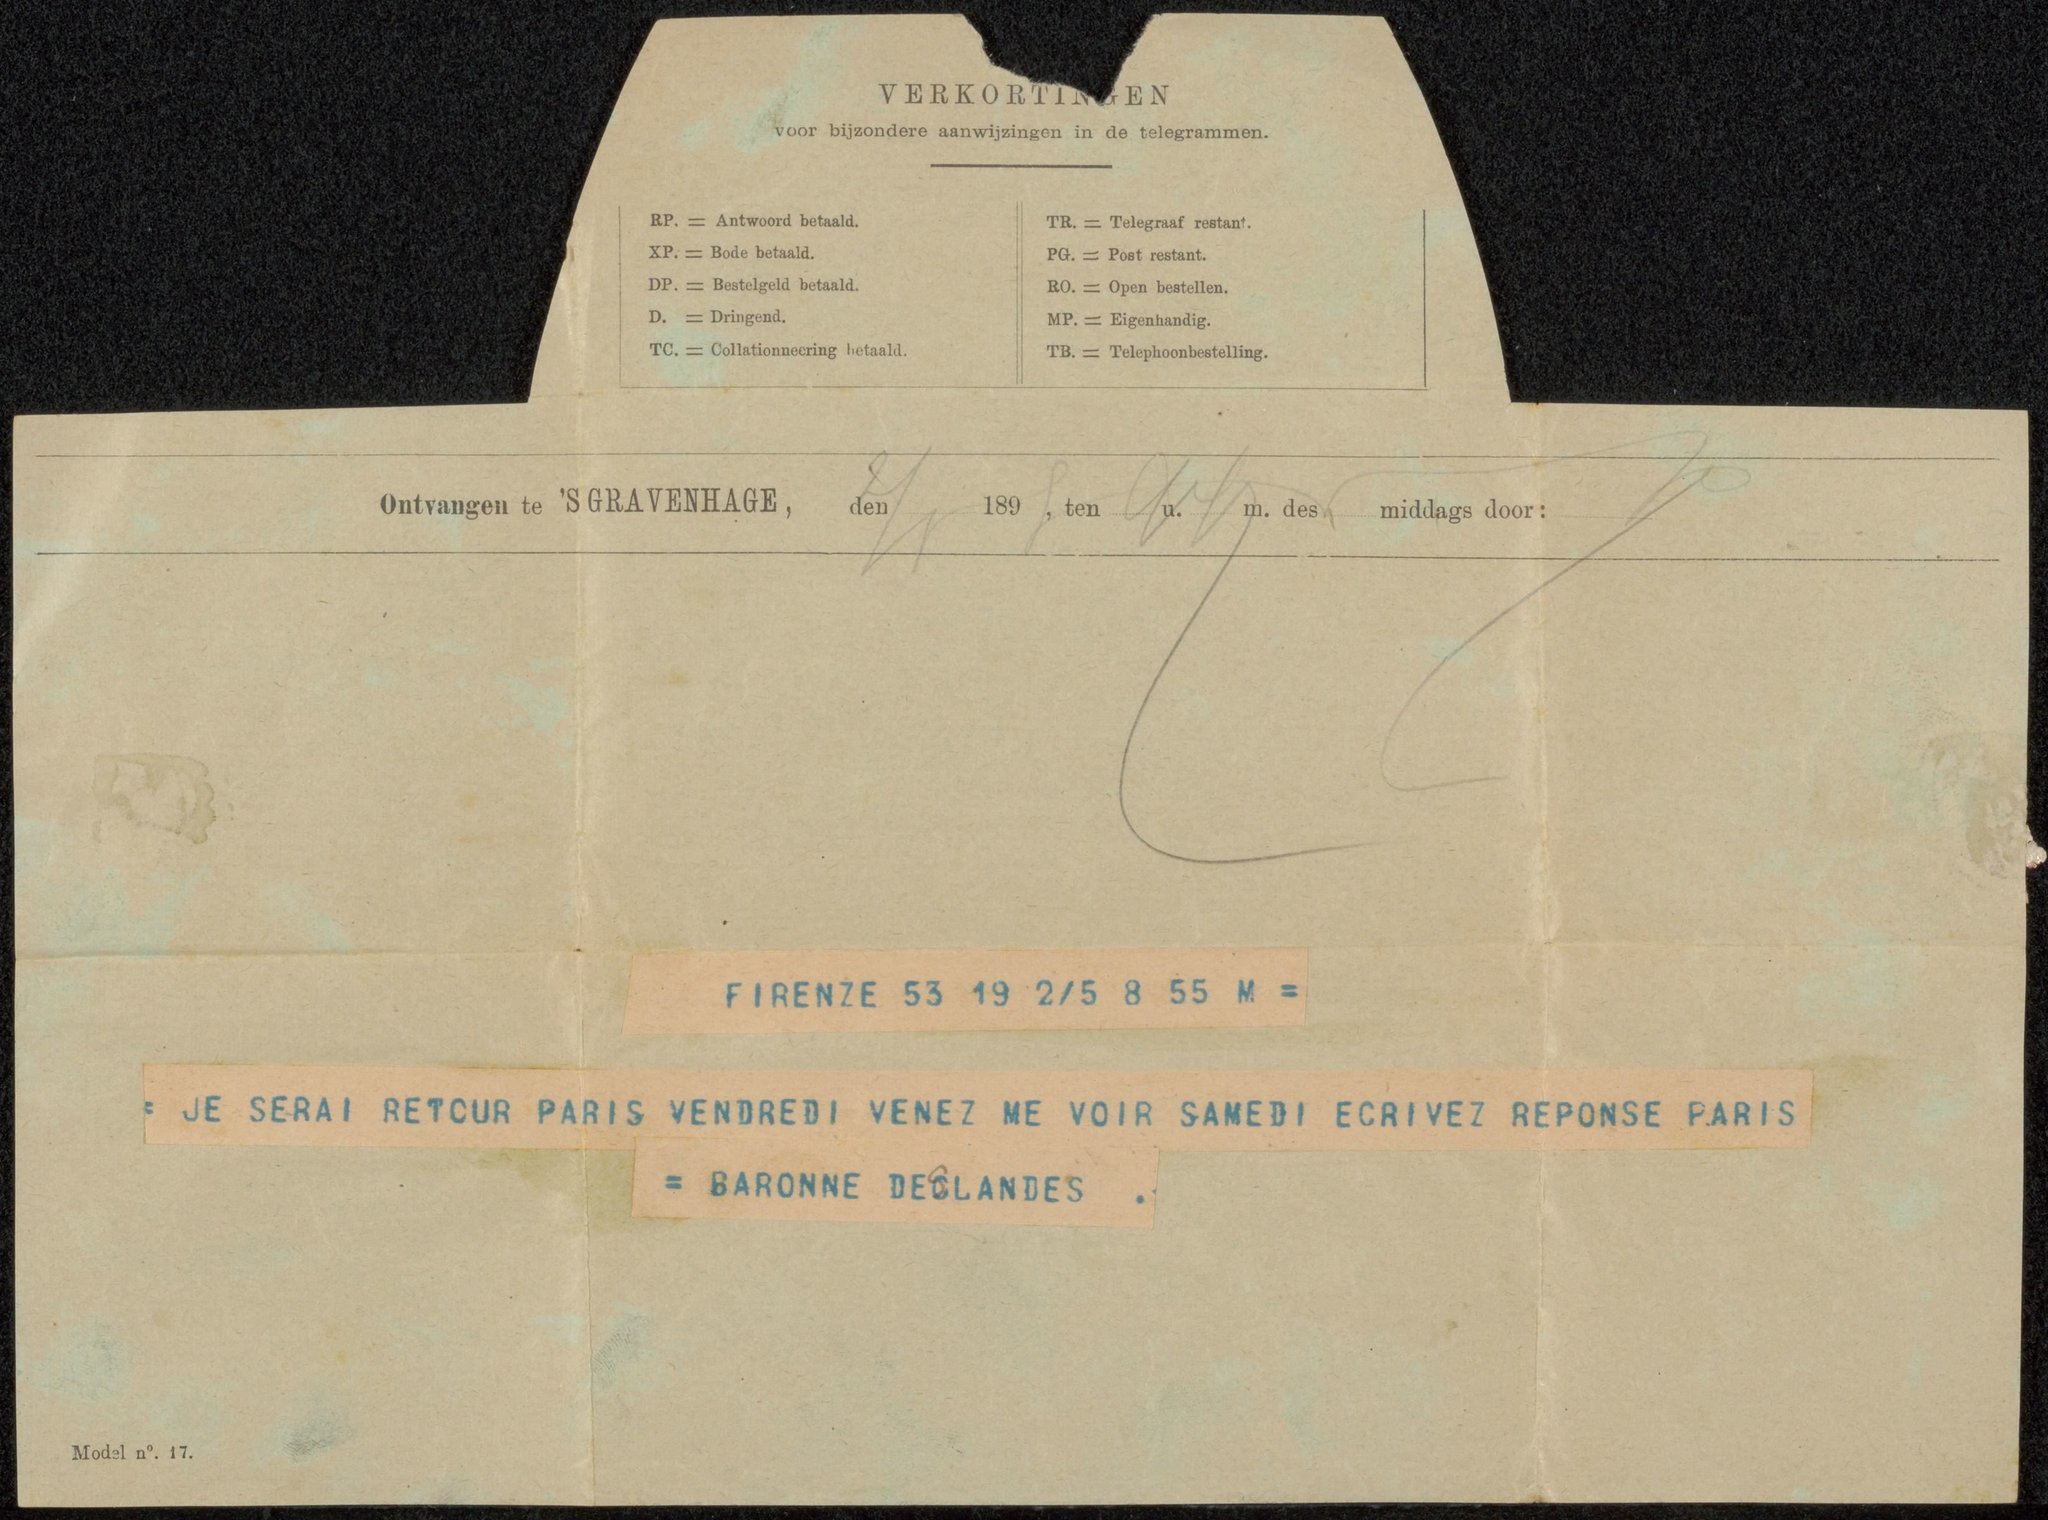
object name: telegram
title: Telegram aan Philip Zilcken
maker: baronne madeleine deslandes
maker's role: schrijver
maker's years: 1866-1929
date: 1899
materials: paper, pencil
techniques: printing, typewriting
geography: florence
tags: the hague, painter, draughtsman, philip zilcken, paris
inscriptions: seal: ‘RIJKSTELEGRAAF’, collector's mark: ‘RPK’